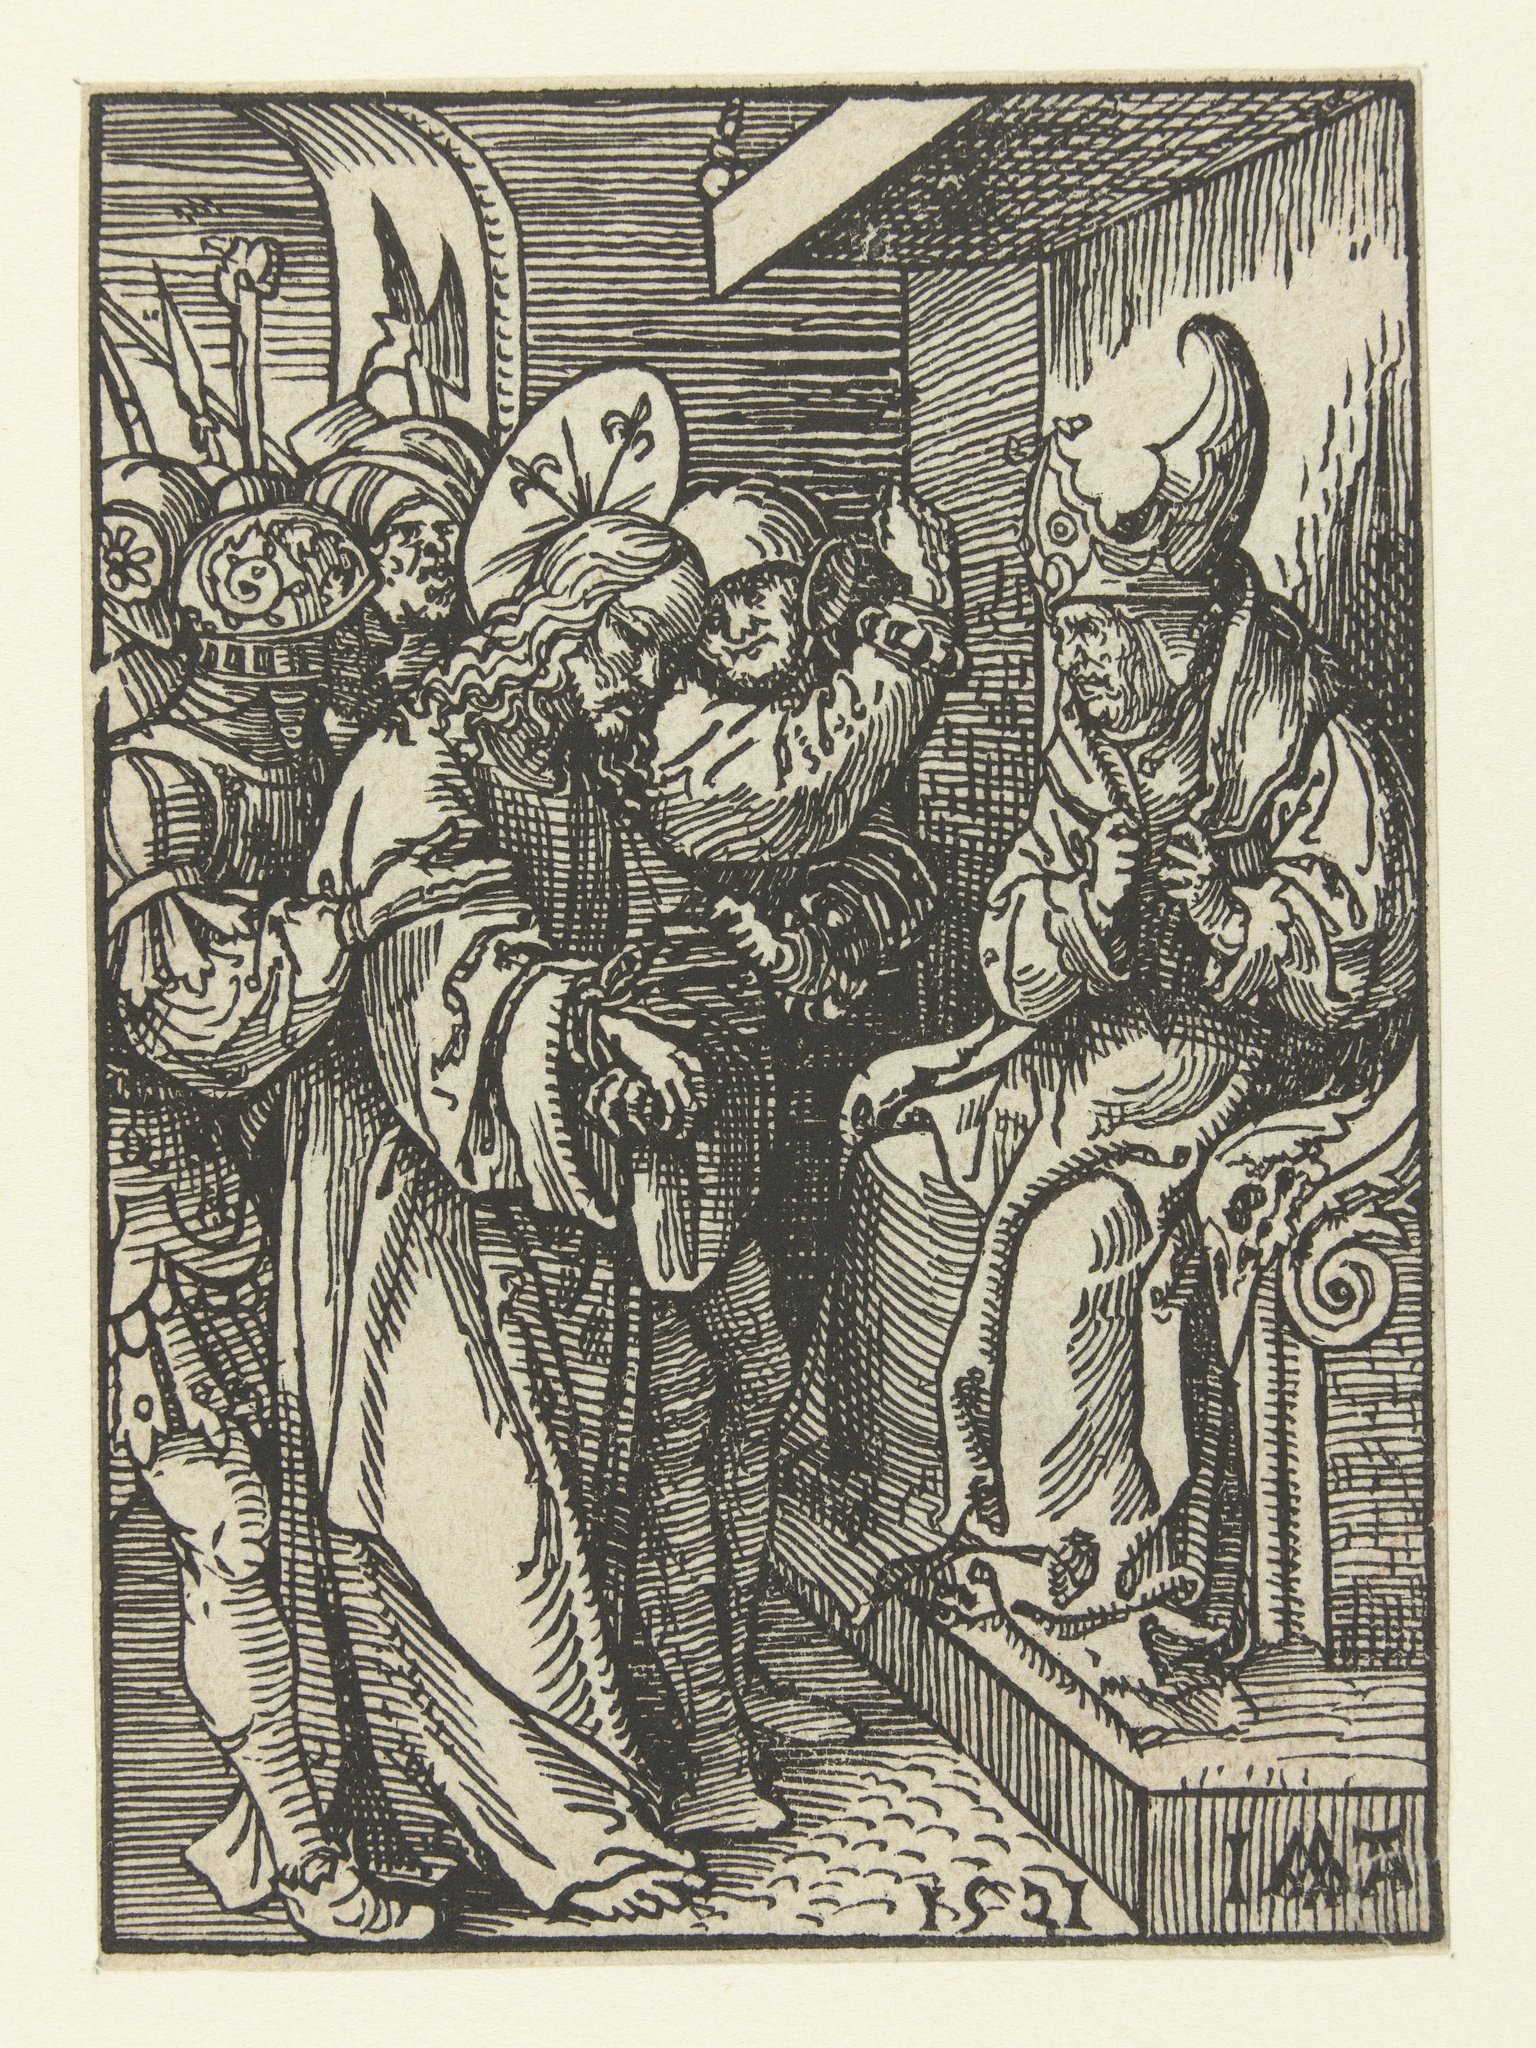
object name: print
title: Christus voor Kajafas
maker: jacob cornelisz van oostsanen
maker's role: draughtsman, painter, print maker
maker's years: 1475-1533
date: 1521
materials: paper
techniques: woodcut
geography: low countries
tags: in caiaphas' palace christ is mocked by jews (matthew 26:67-68; mark 14:65)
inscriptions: collector's mark: Lugt 240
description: Uit serie van 66 prenten. Proefdruk, geen tekst op verso.